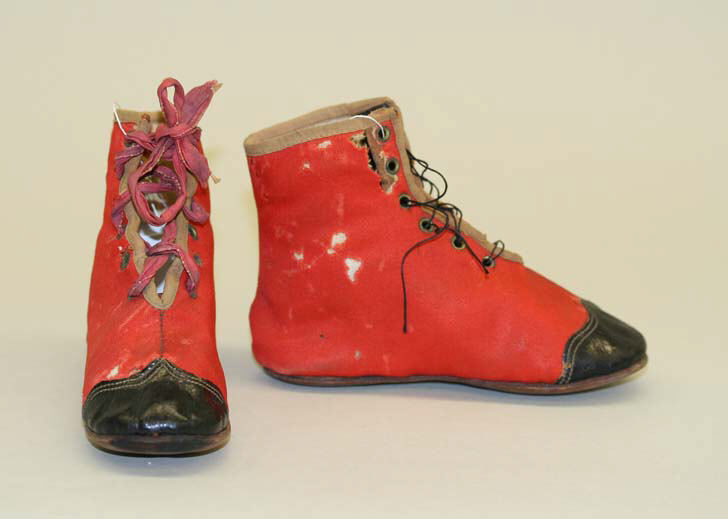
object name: boot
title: Boots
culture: american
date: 1870